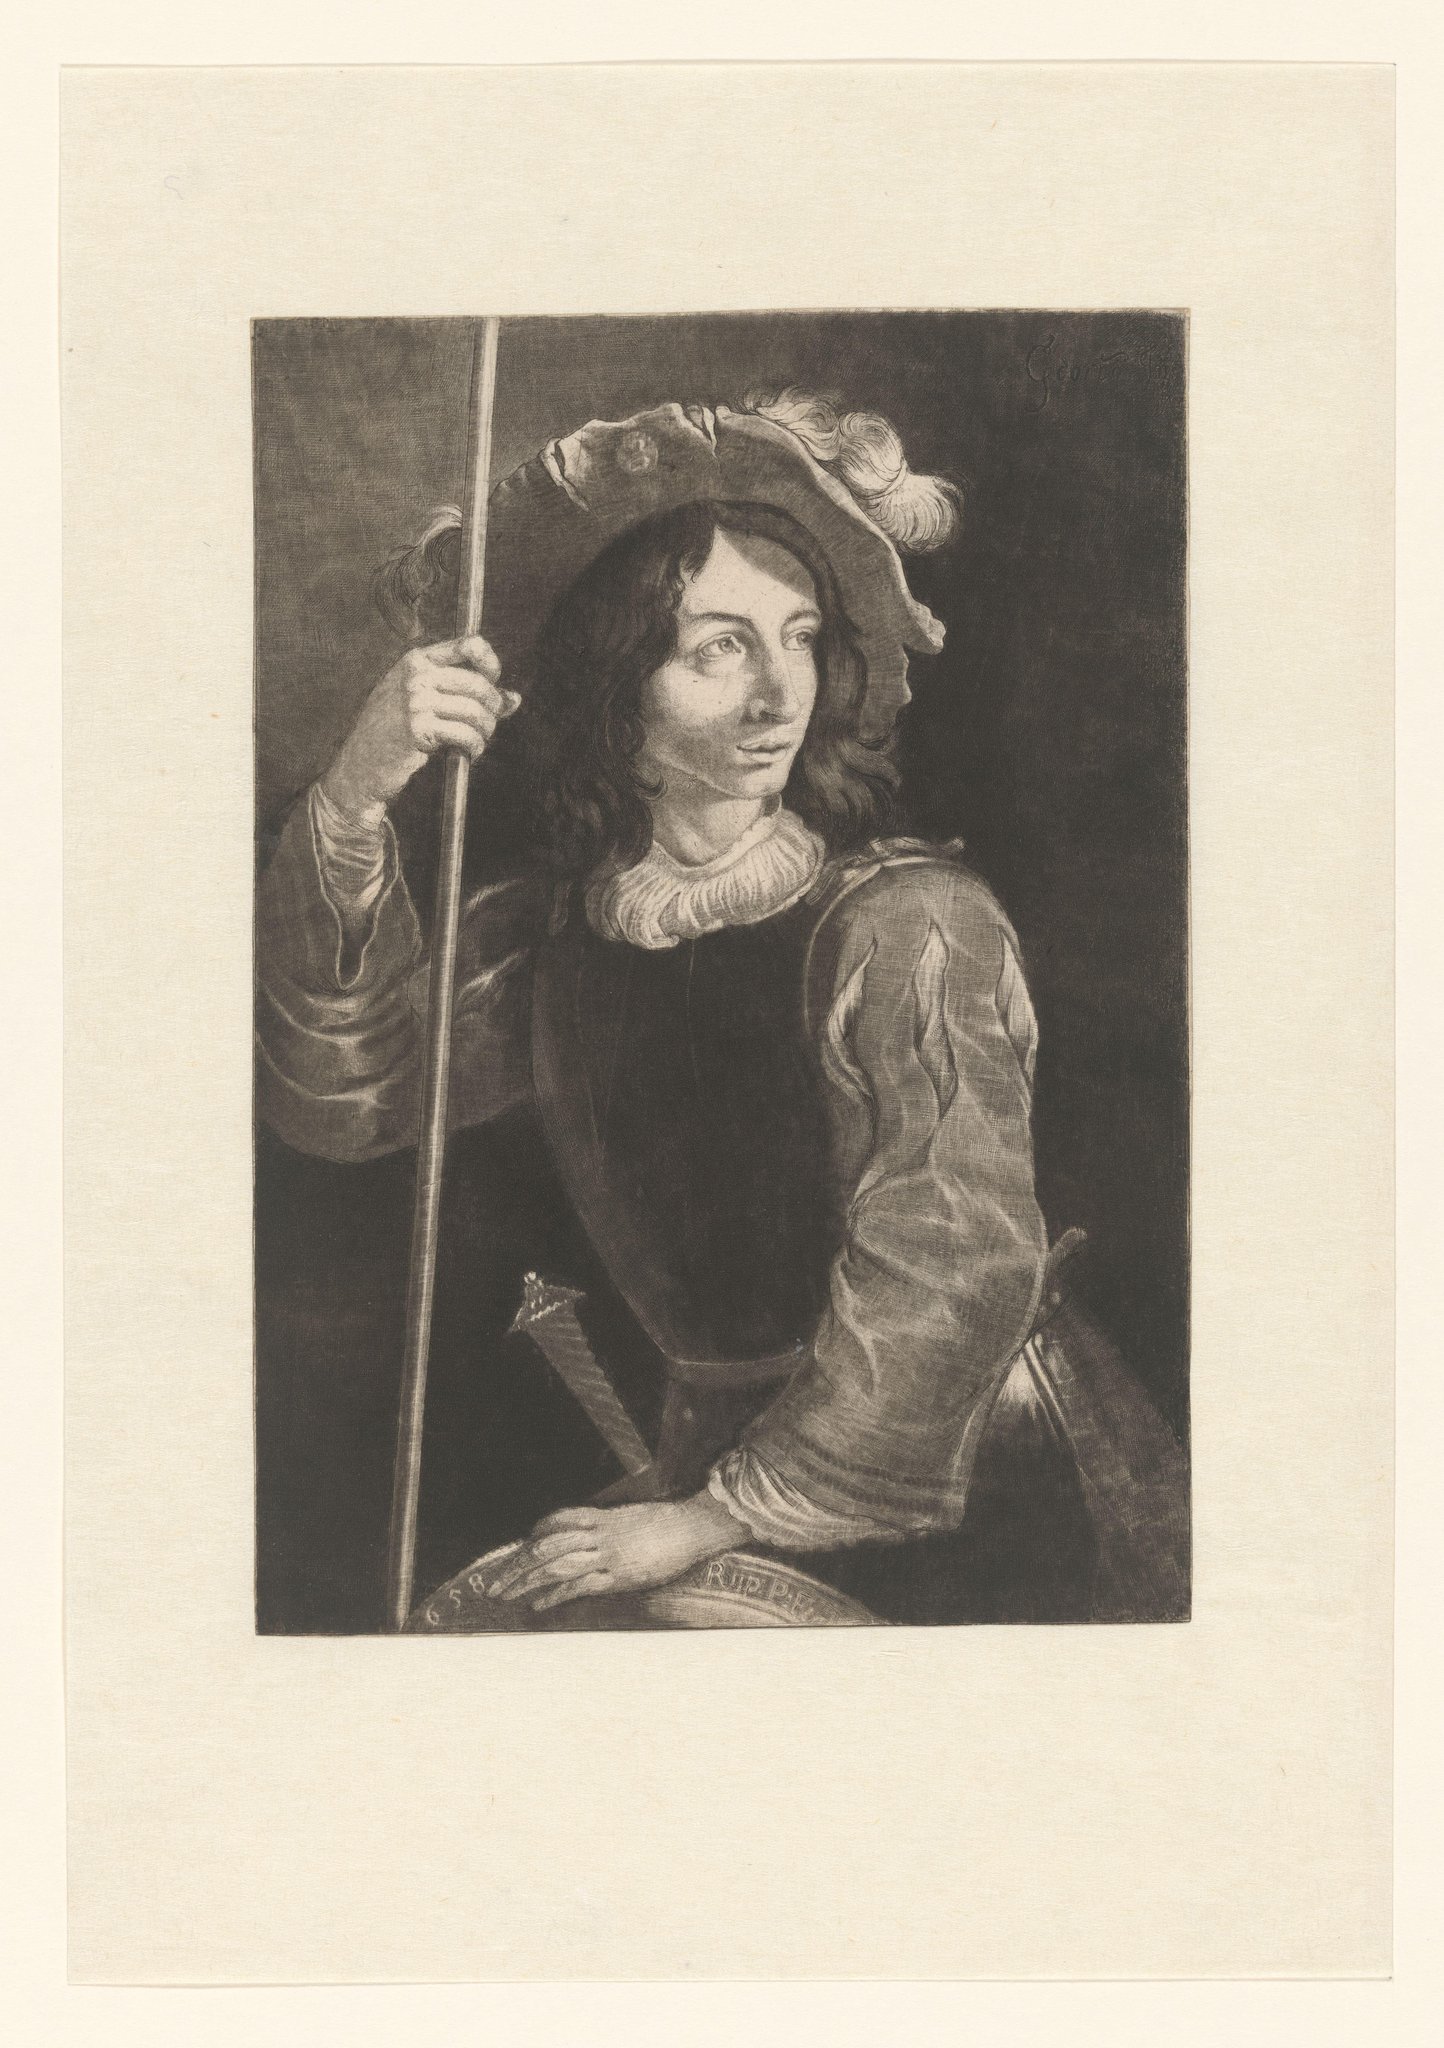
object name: print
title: Vaandeldrager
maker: prinz ruprecht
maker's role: draughtsman, painter, print maker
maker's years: 1619-1682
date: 1658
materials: paper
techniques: etching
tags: standard-bearer, flag-bearer, youth, adolescent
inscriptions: collector's mark: Lugt 2166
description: Op de achterzijde is met rood krijt licht het contour van het hoofd overgetrokken.